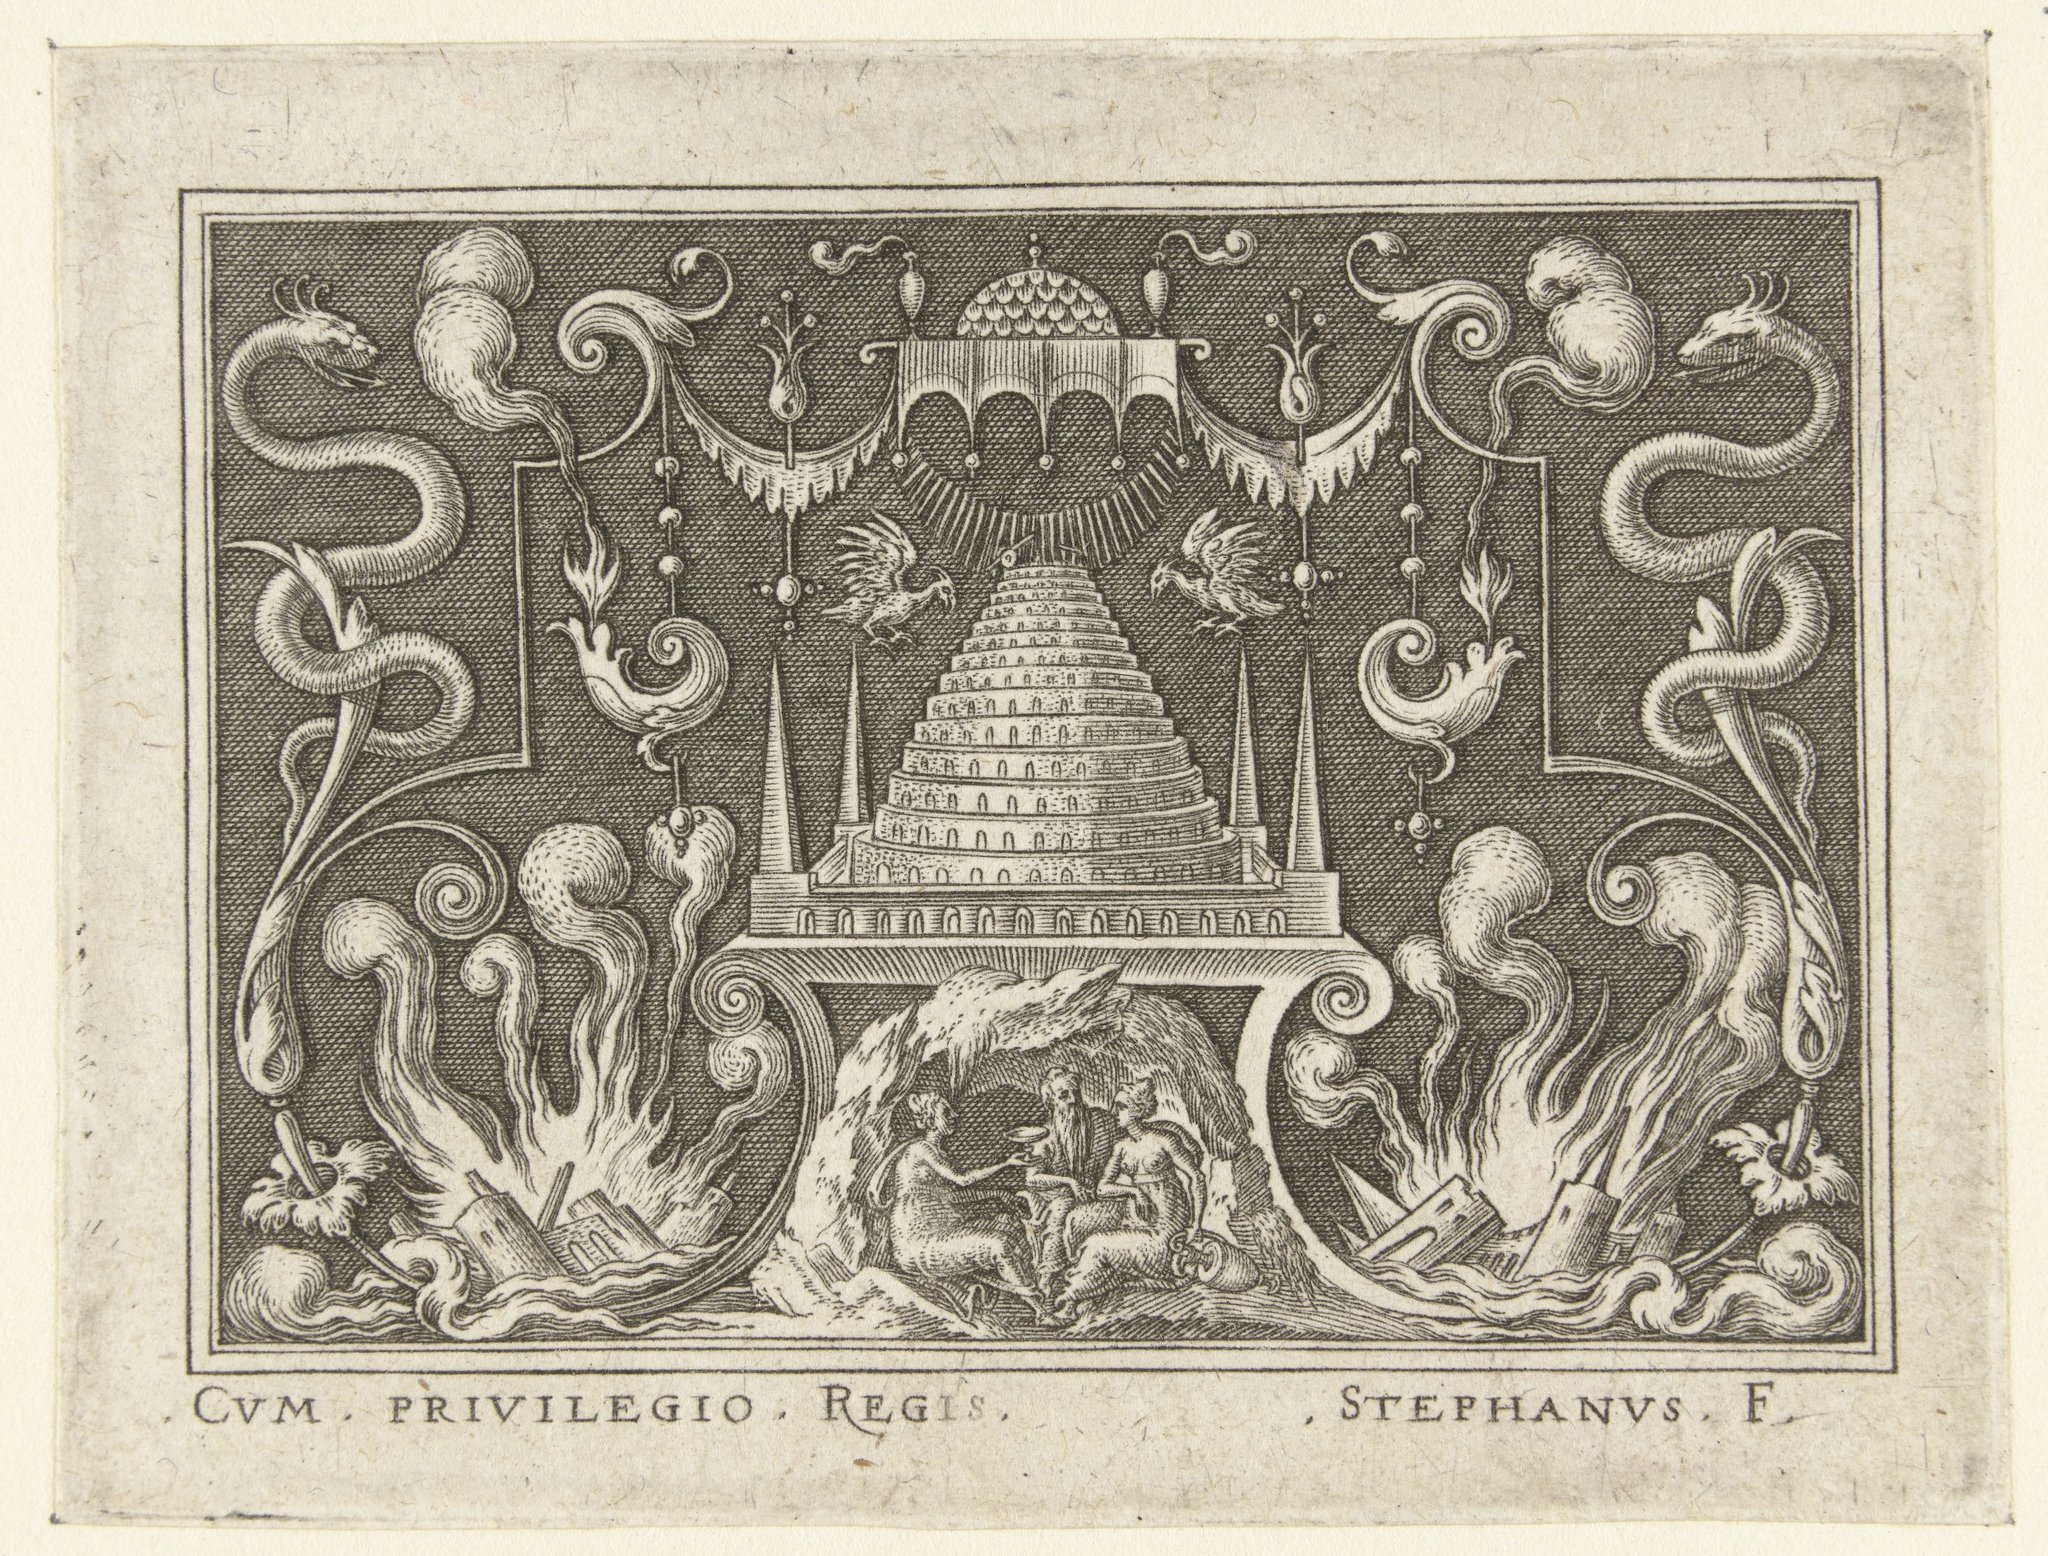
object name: ornament print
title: Toren van Babel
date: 1528-1583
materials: paper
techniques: engraving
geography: france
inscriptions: collector's mark: Lugt 240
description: Onder de toren zitten Loth en zijn dochters in een grot. Uit serie van 6 bladen.